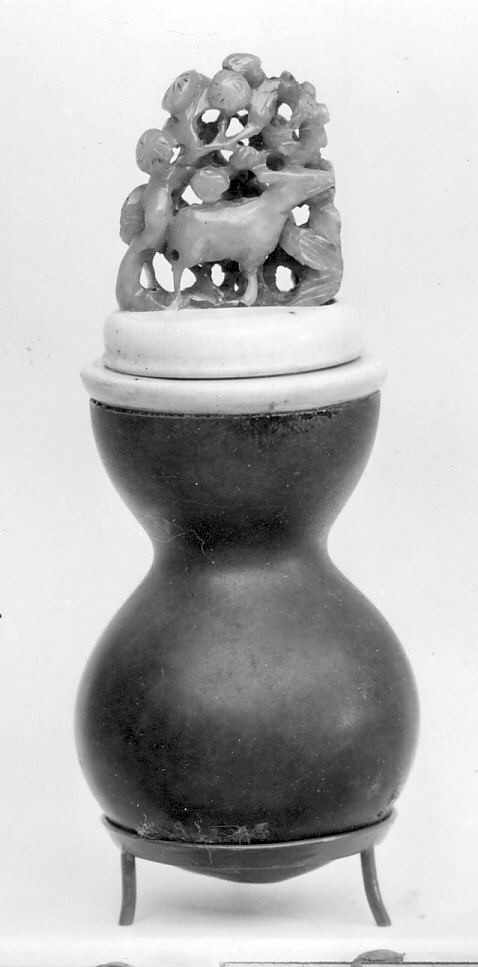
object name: cricket cage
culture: chinese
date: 1701-1900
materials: ivory, jade